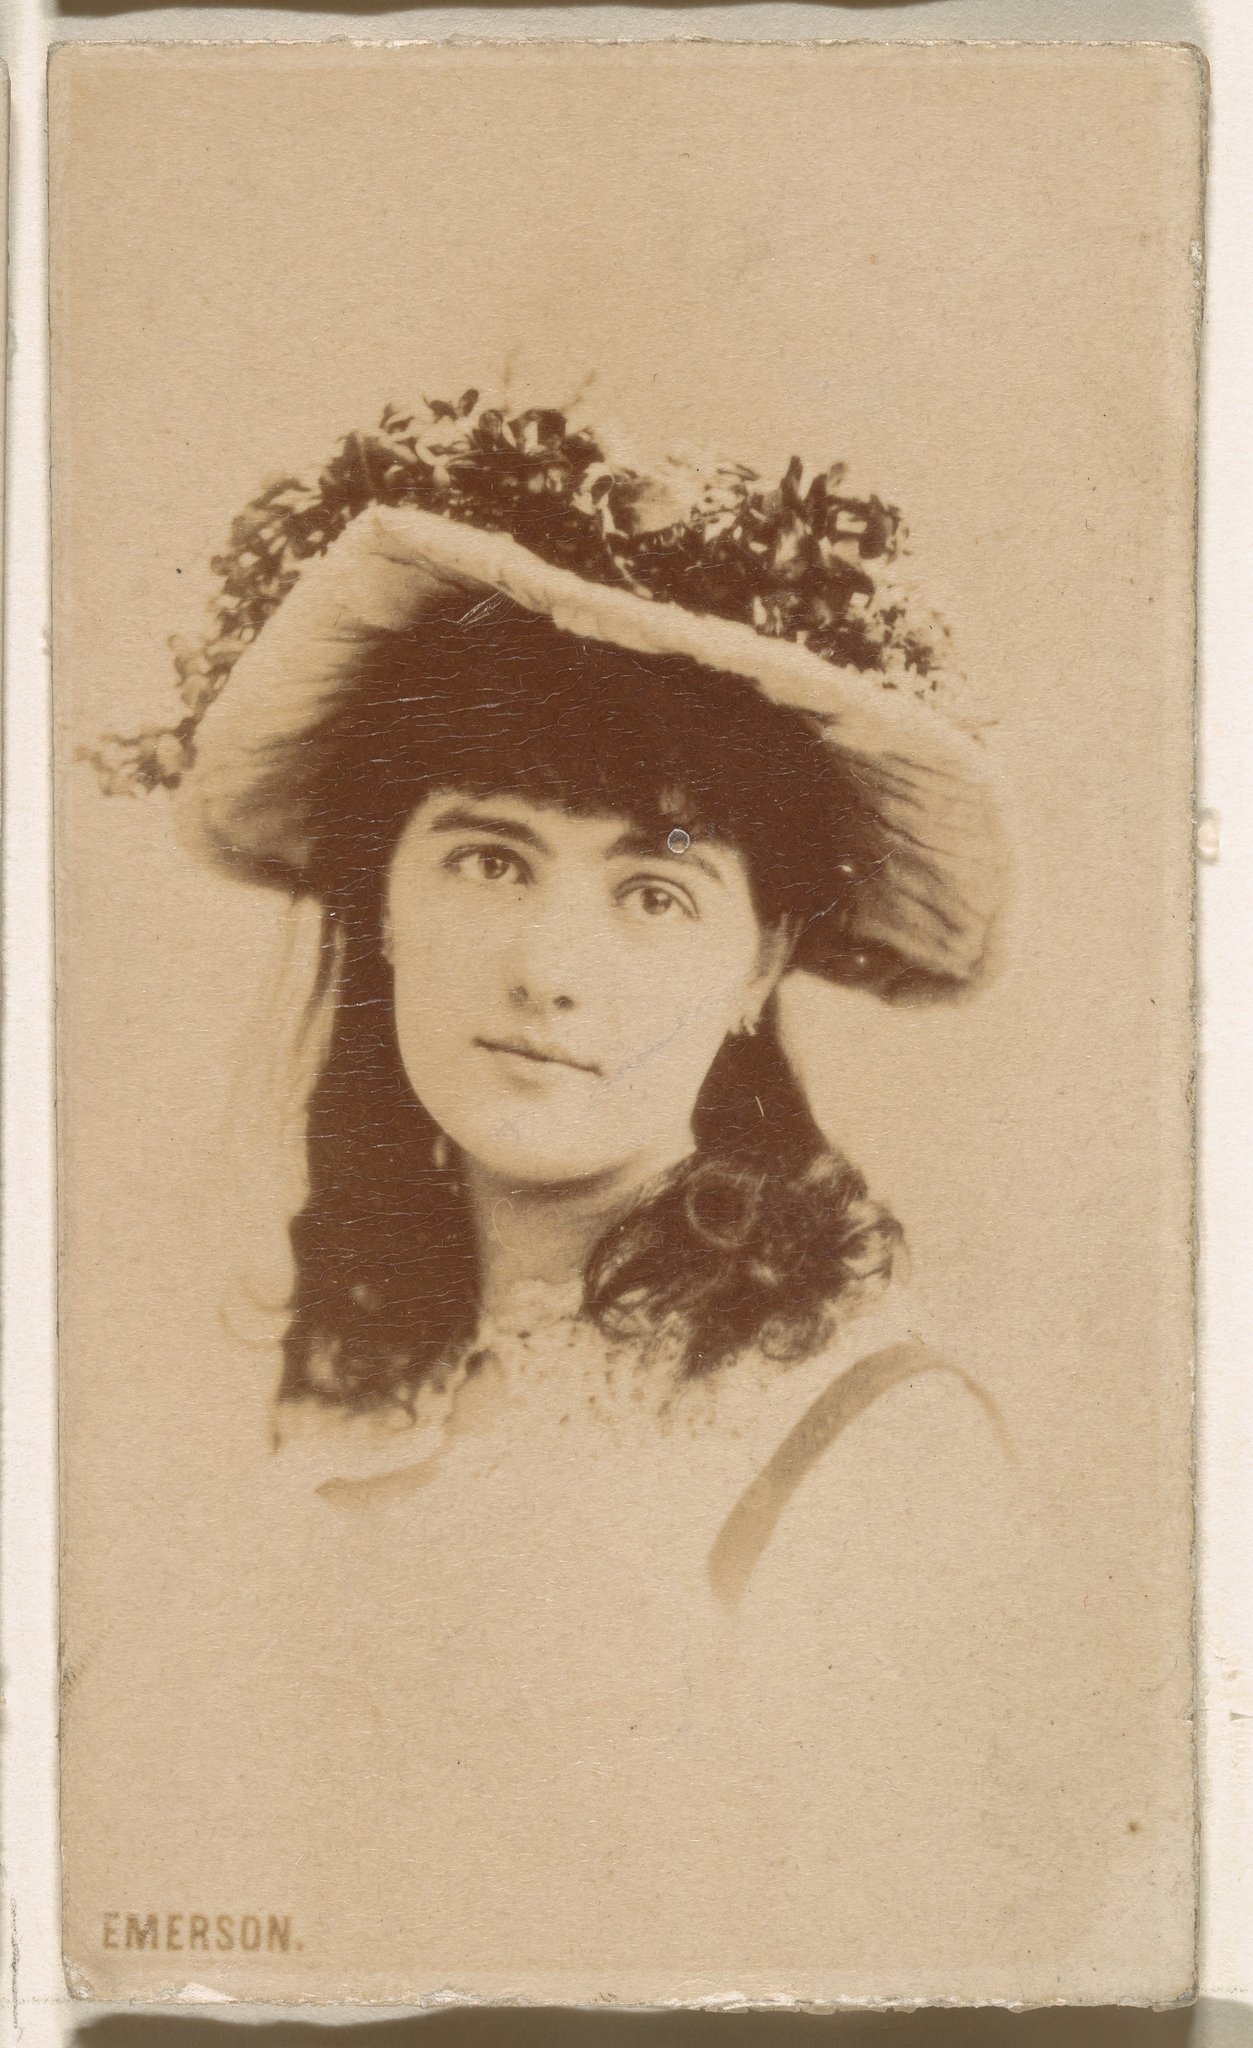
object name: photograph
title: Miss Emerson, from the Actresses series (N246), Type 1, issued by Kinney Brothers to promote Sporting Extra Cigarettes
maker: kinney brothers tobacco company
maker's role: publisher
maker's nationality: american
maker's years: 1869-2011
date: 1890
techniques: albumen silver print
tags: portraits,women,actresses